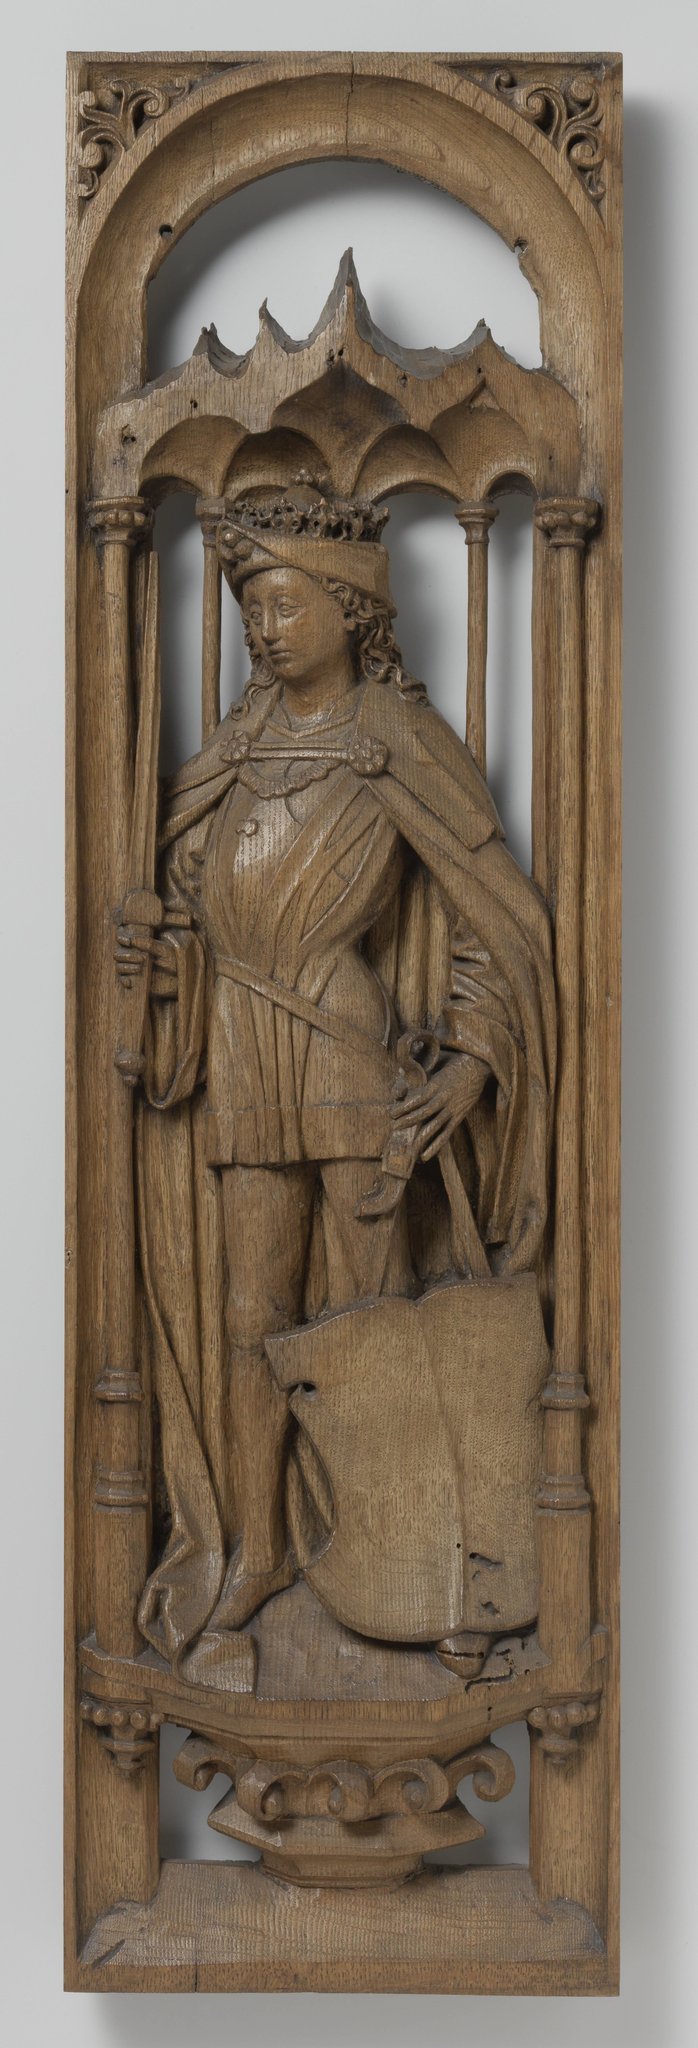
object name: orgelkast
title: Panel with a Knight Supporting an Escutcheon, from the Organ of the Sint-Vituskerk, Naarden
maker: jan eerstensz van schayck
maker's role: sculptor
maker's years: 1470-1527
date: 1510-1520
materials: wood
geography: utrecht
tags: knight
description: These ten figures adorned the medieval organ in the church of Saint Vitus in Naarden. Each figure holds a weapon and a coat of arms on a strap. Some are dressed as knights with a breastplate and a helmet, others as princes or noblemen. They may represent the Counts of Holland. All the shields would have originally been painted.